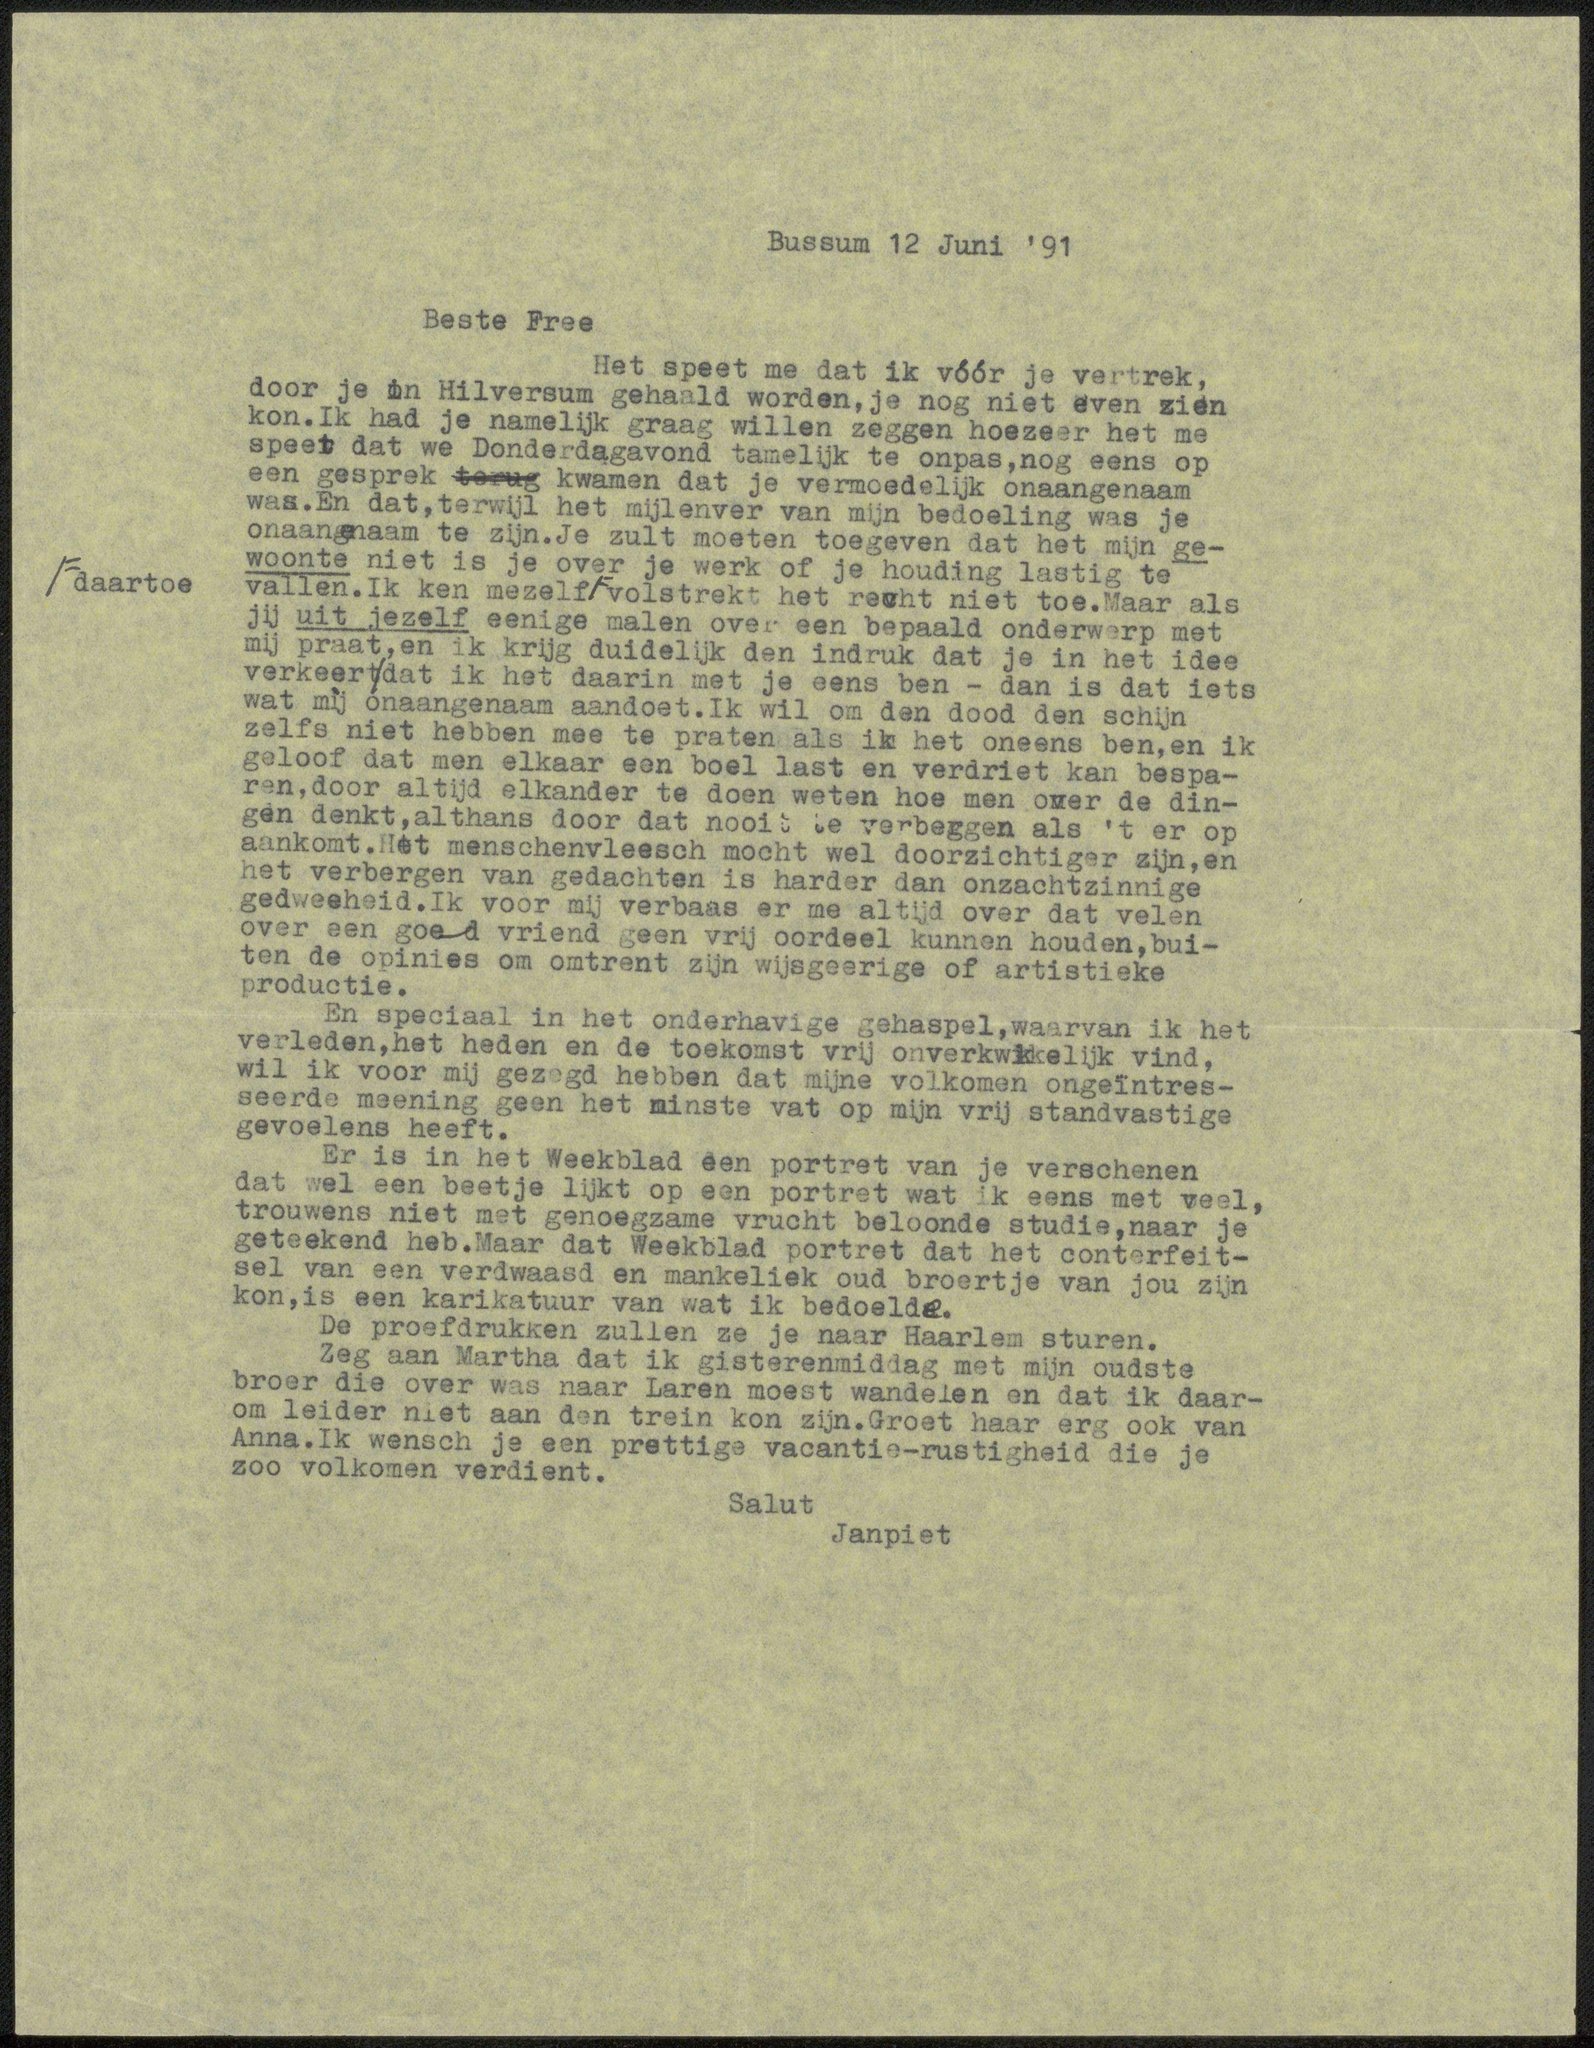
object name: letter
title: Afschrift van een brief aan Frederik van Eeden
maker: Anonymous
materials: ink, paper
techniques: typewriting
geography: bussum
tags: frederik van eeden, historical persons (portraits and scenes from the life)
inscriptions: collector's mark: ‘RPK’